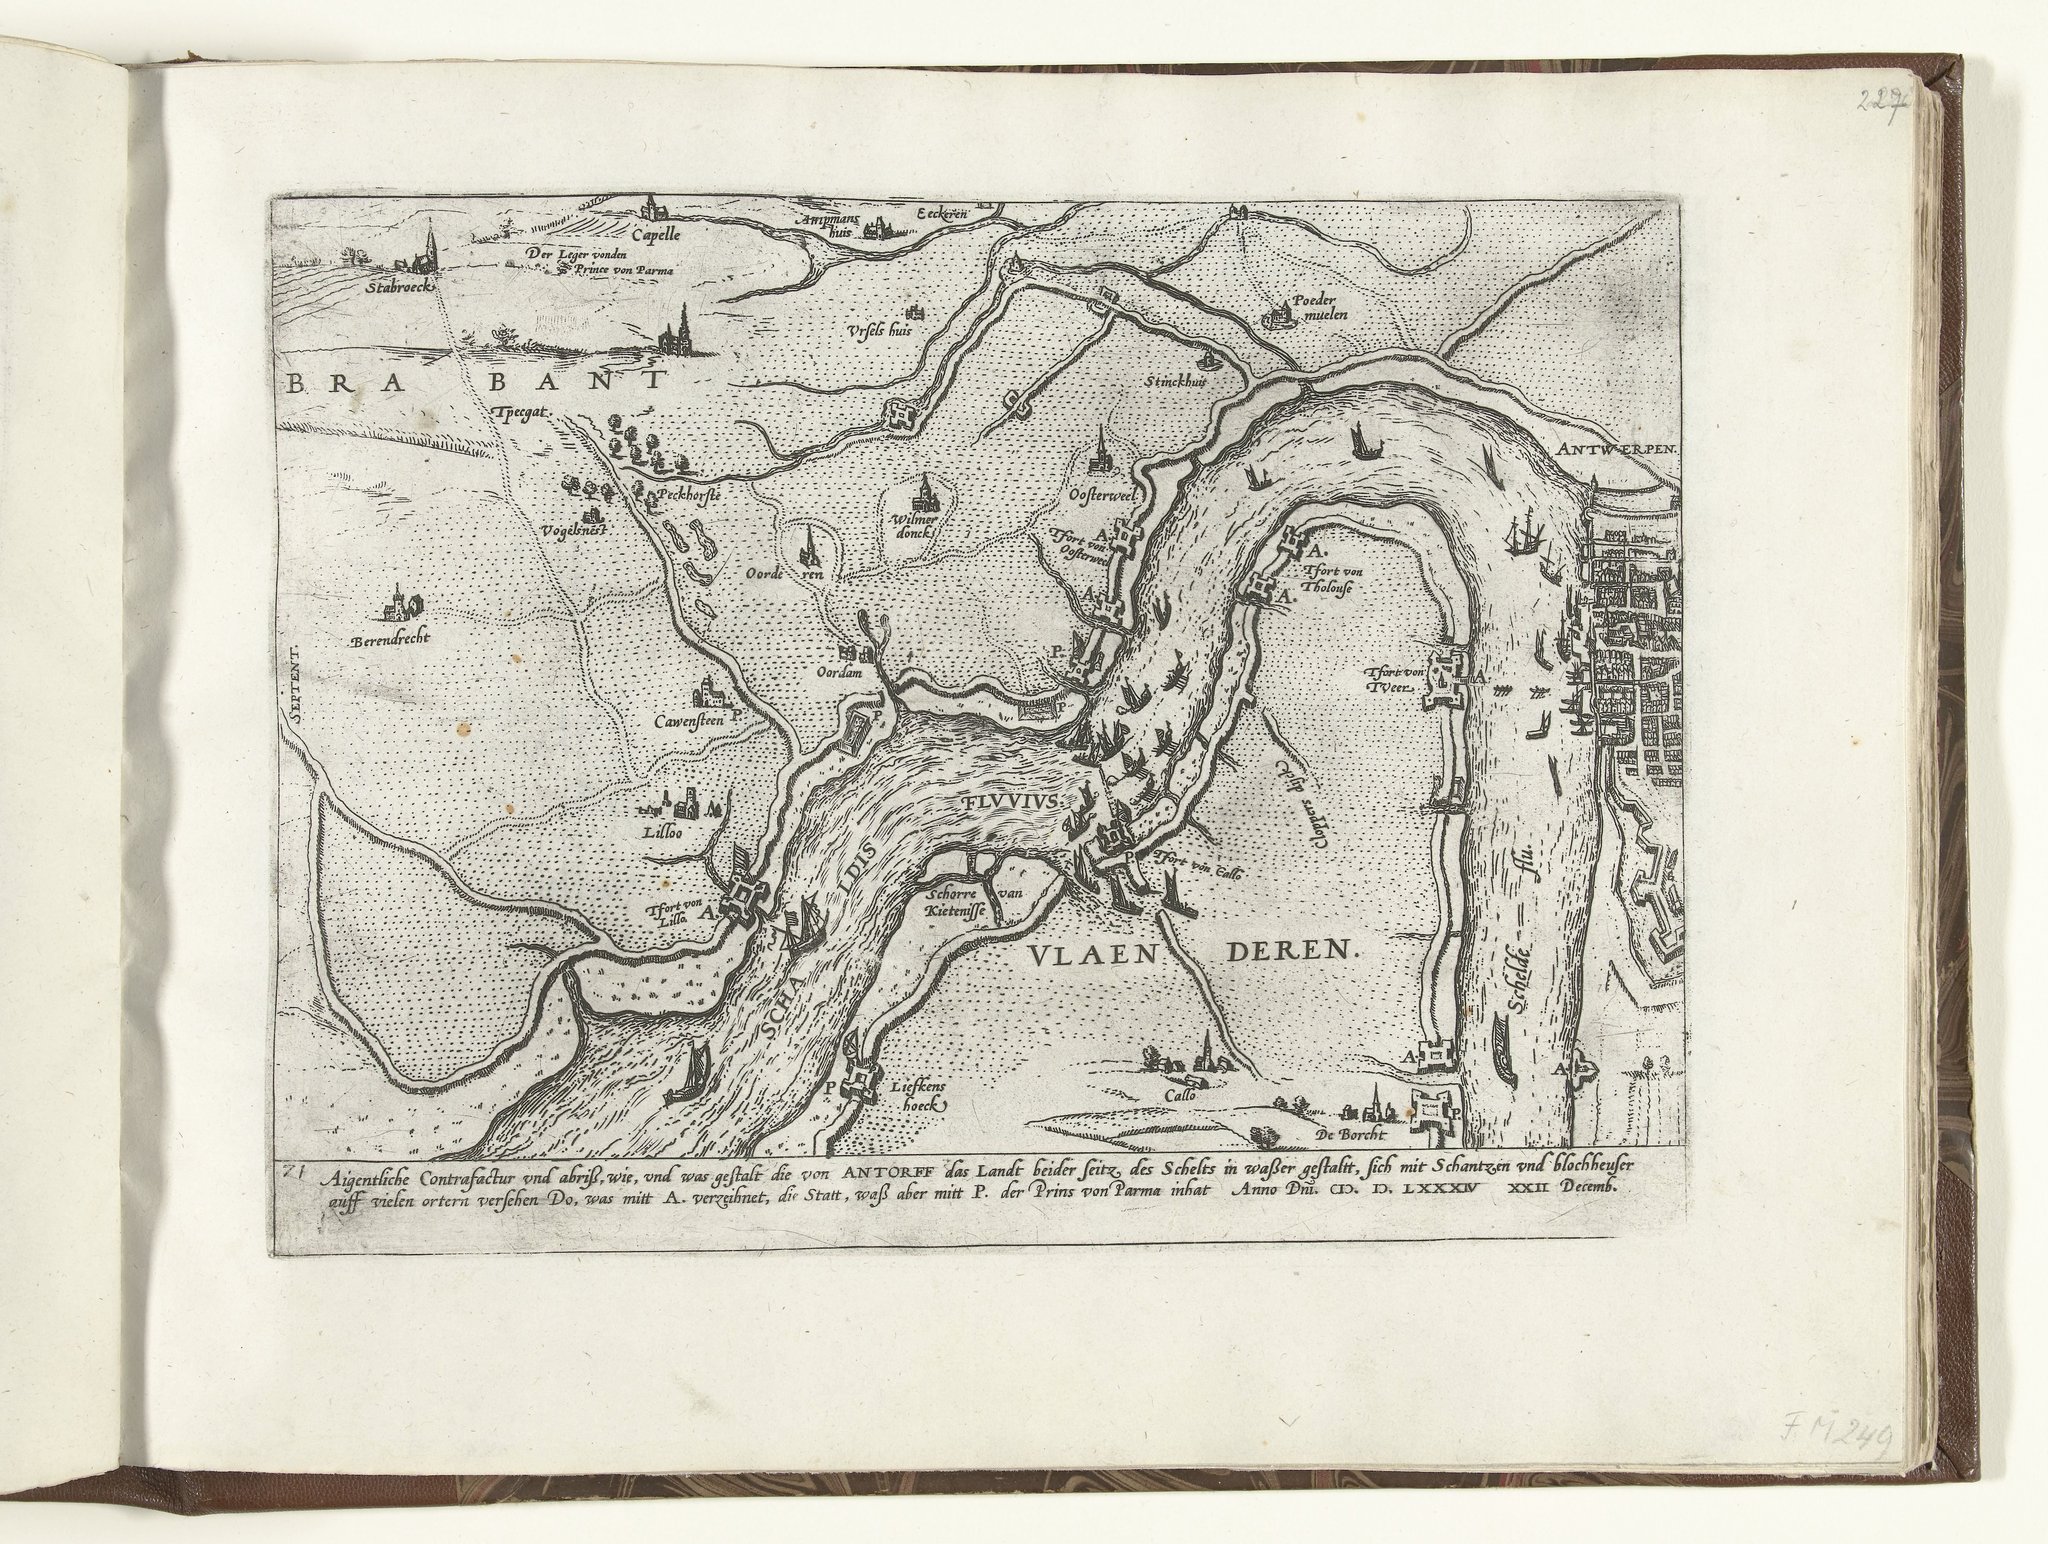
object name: print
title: Serie 9: Nederlandse en Duitse Gebeurtenissen, 1583-1587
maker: frans hogenberg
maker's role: print maker, publisher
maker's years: 1538-1590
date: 1584-1586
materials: paper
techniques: etching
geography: cologne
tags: rome, alessandro farnese (landvoogd van de nederlanden en hertog van parma en piacenza), maps of separate countries or regions, fortifications, military engineering, antwerp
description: Kaart met een overzicht van de fortificaties langs de Schelde, 22 december 1584. De forten van Antwerpen zijn met de letter A gemerkt, die van Parma met een P. Met onderschrift van 2 regels in het Duits. Genummerd: 71.